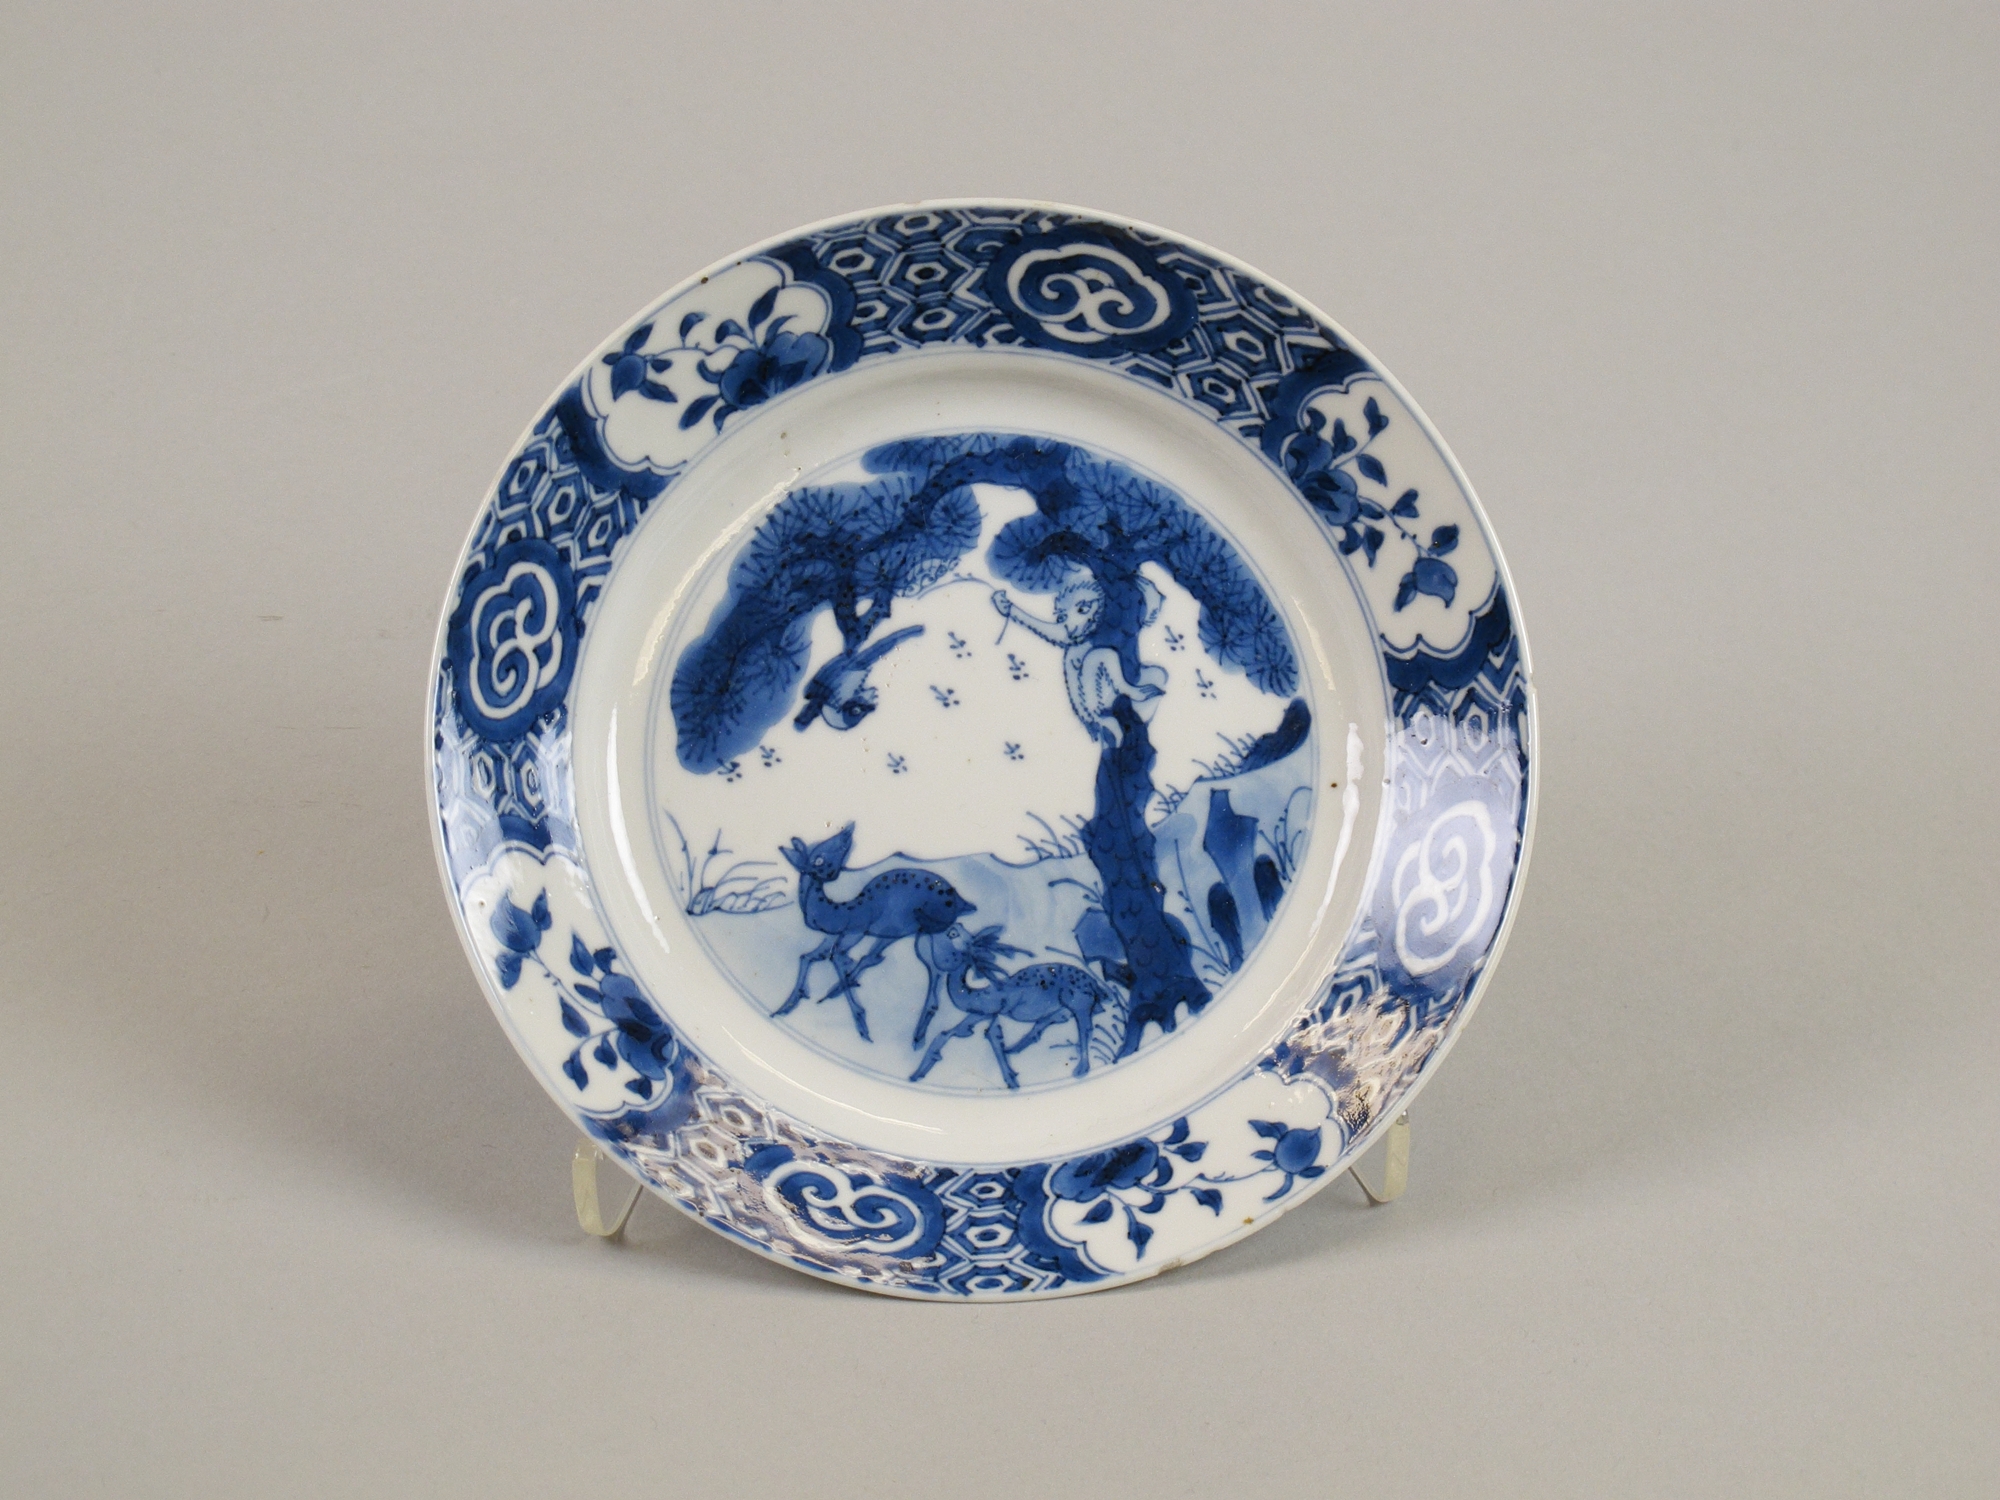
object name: plate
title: Plate with Monkey, Bees, Magpie, and Deer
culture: chinese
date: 1667-1733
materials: porcelain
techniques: painting, underglaze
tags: birds,deer,monkeys,trees